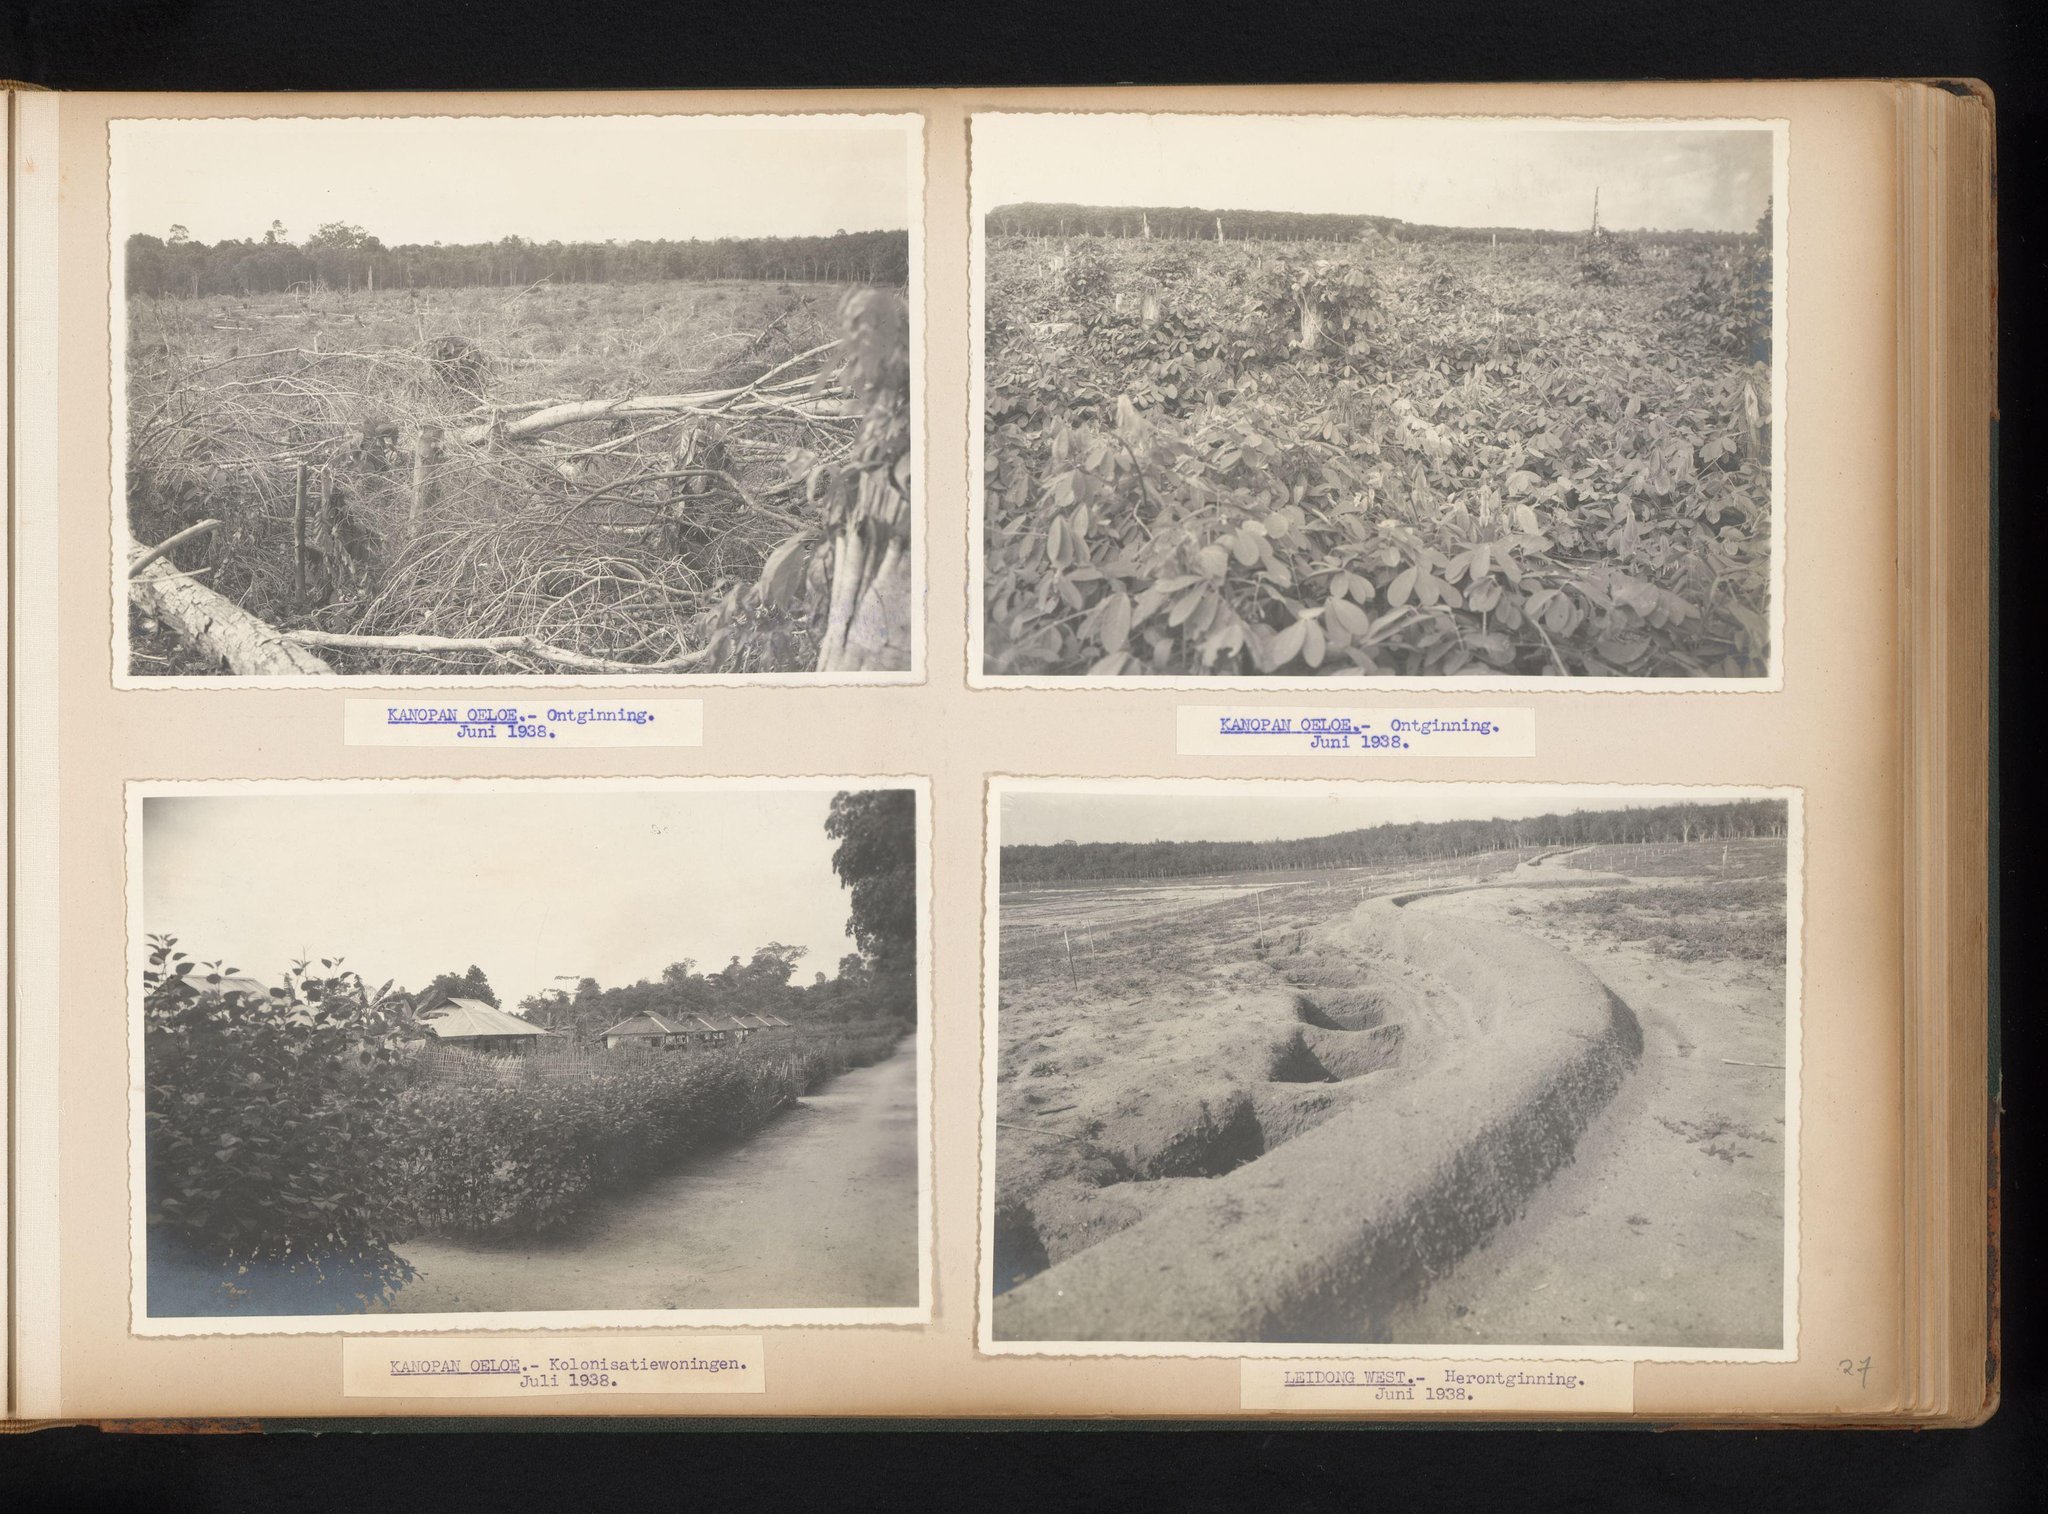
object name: album leaf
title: Ontginning en 'kolonisatiewoningen' op Kanopan Oeloe, 1938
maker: Anonymous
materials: cardboard, photographic support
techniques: gelatin silver print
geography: sumatra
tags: plantation, (non-fruit) products of plants or trees: rubber, rural housing, e.g. country-house, villa, cottage, sumatra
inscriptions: inscription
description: Blad met vier foto's van ontginning en 'kolonisatiewoningen' op Kanopan Oeloe en herontginning op Leidong West, juni-juli 1938. Onderdeel van het fotoalbum over de plantages Leidong West en Kanopan Oeloe van de Cultuur Maatschappij Leidong West op Sumatra in de jaren 1925-1939.